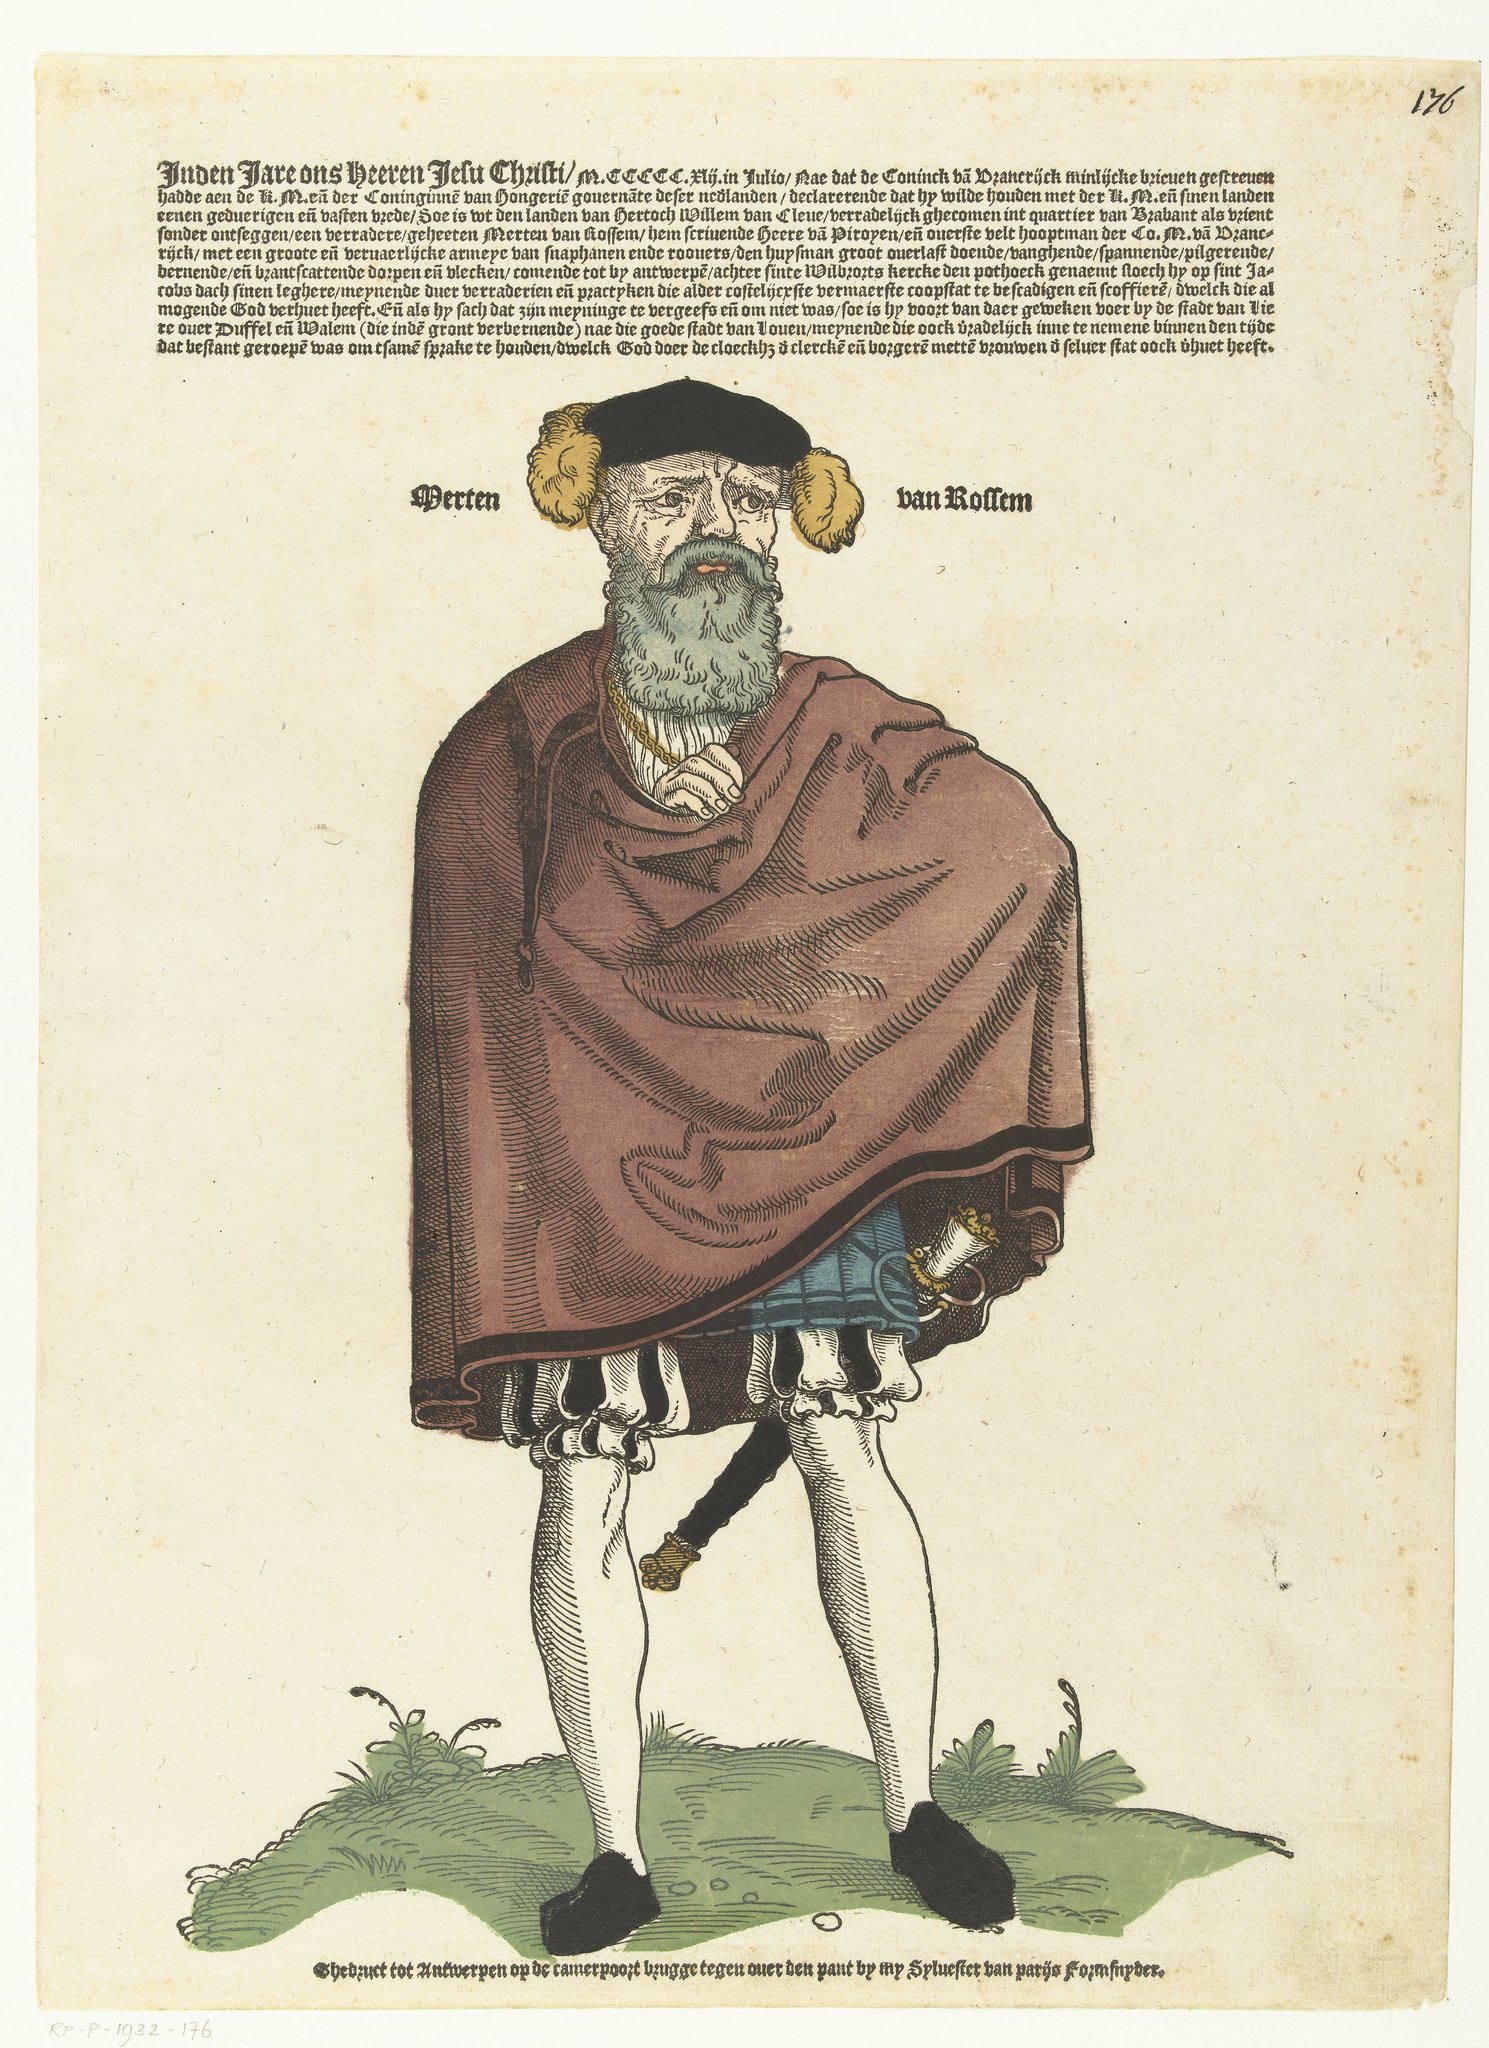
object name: print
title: Portret van Maarten van Rossum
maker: sylvester van parijs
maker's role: publisher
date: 1542-1548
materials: paper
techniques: hand coloring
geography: antwerp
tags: antwerp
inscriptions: number: ‘176’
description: Maarten van Rossum ten voeten uit. Bovenaan tienregelige tekst in het Nederlands. Links en rechts van zijn hoofd zijn naam. Uitgegeven als vlugschrift; drukte de woede van bevolking uit over de aanslag op Antwerpen in 1542.